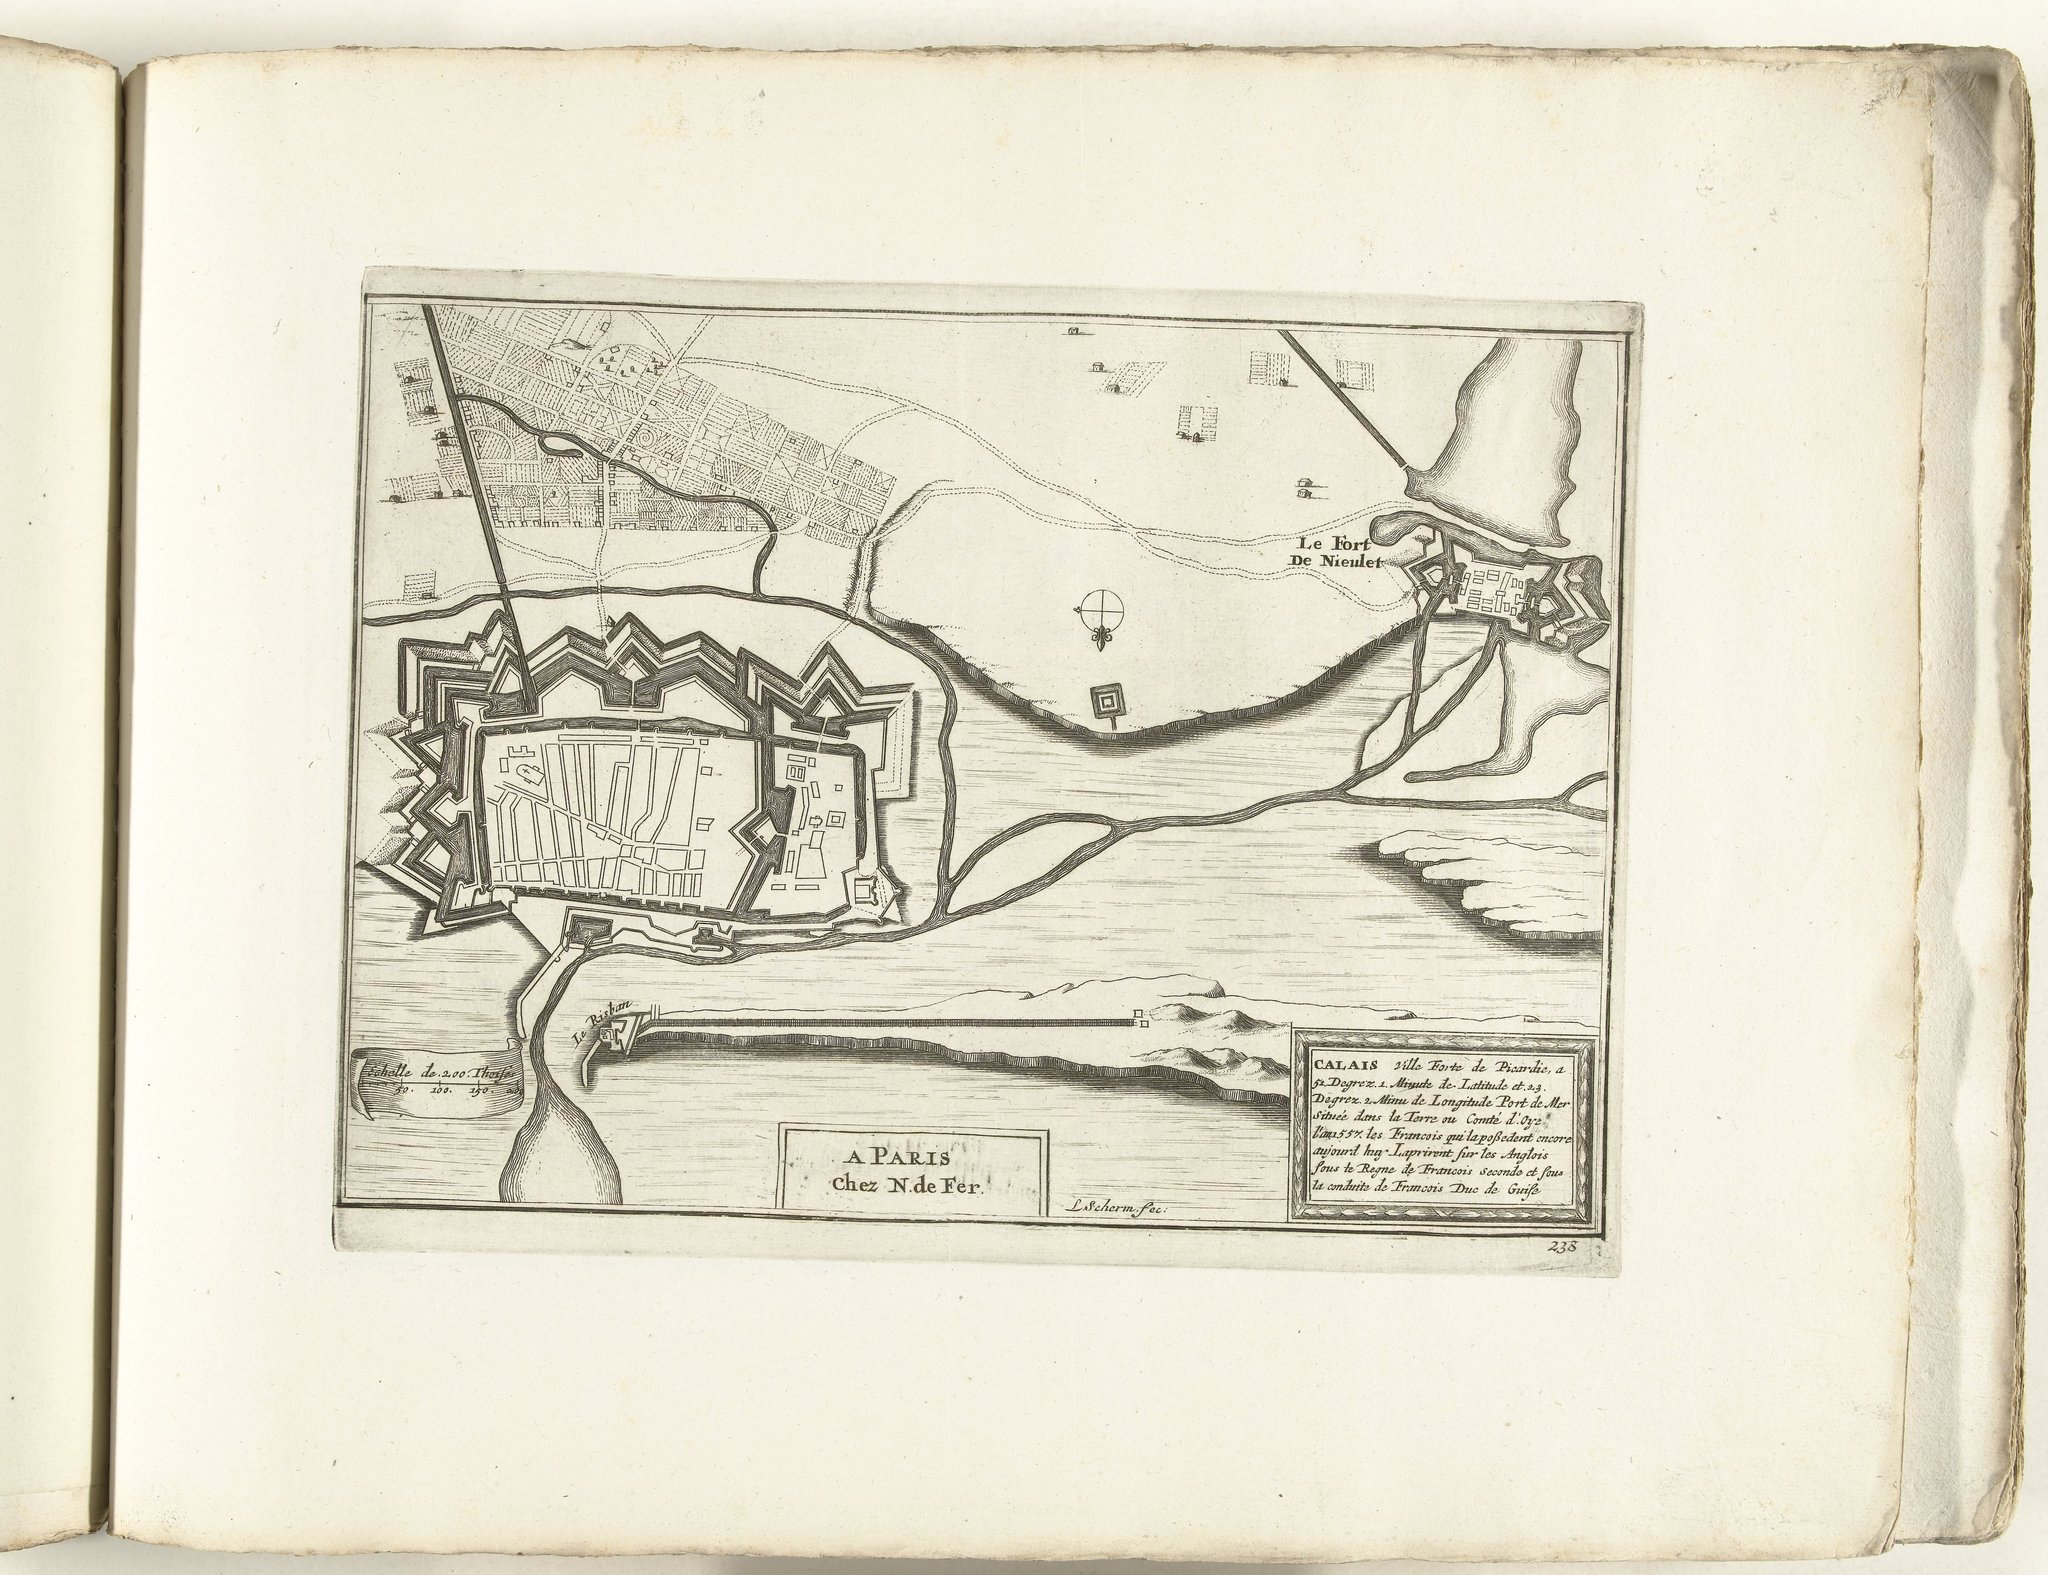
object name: map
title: Les Forces de l'Europe, Asie, Afrique et Amerique, ou description des principales villes avec leurs fortifications. Dessignées par les meilleurs ingenieurs, particulierement celles qui sont sous la domination de la France (...) et ornées de plusieurs superbes edifices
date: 1702-1703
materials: paper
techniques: etching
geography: paris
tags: fortress, maps of cities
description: Plattegrond van de versterkingen om de Franse stad Calais. Plaat nr. 238 in het prentwerk bestaande in totaal uit 276 genummerde platen van vermaarde sterke steden en vestingen in het kader van de Spaanse Successieoorlog. Voor het merendeel zijn deze platen gekopieerd naar de anonieme Franse platen: in Les forces de l'Europe en in: Le theatre de la guerre, dans les Pays-Bas, beide oorspronkelijk uitgegeven door Nicolas de Fer te Parijs (1693-1697) in het kader van de Negenjarige Oorlog. Titel en opschriften in de plaat in het Frans.